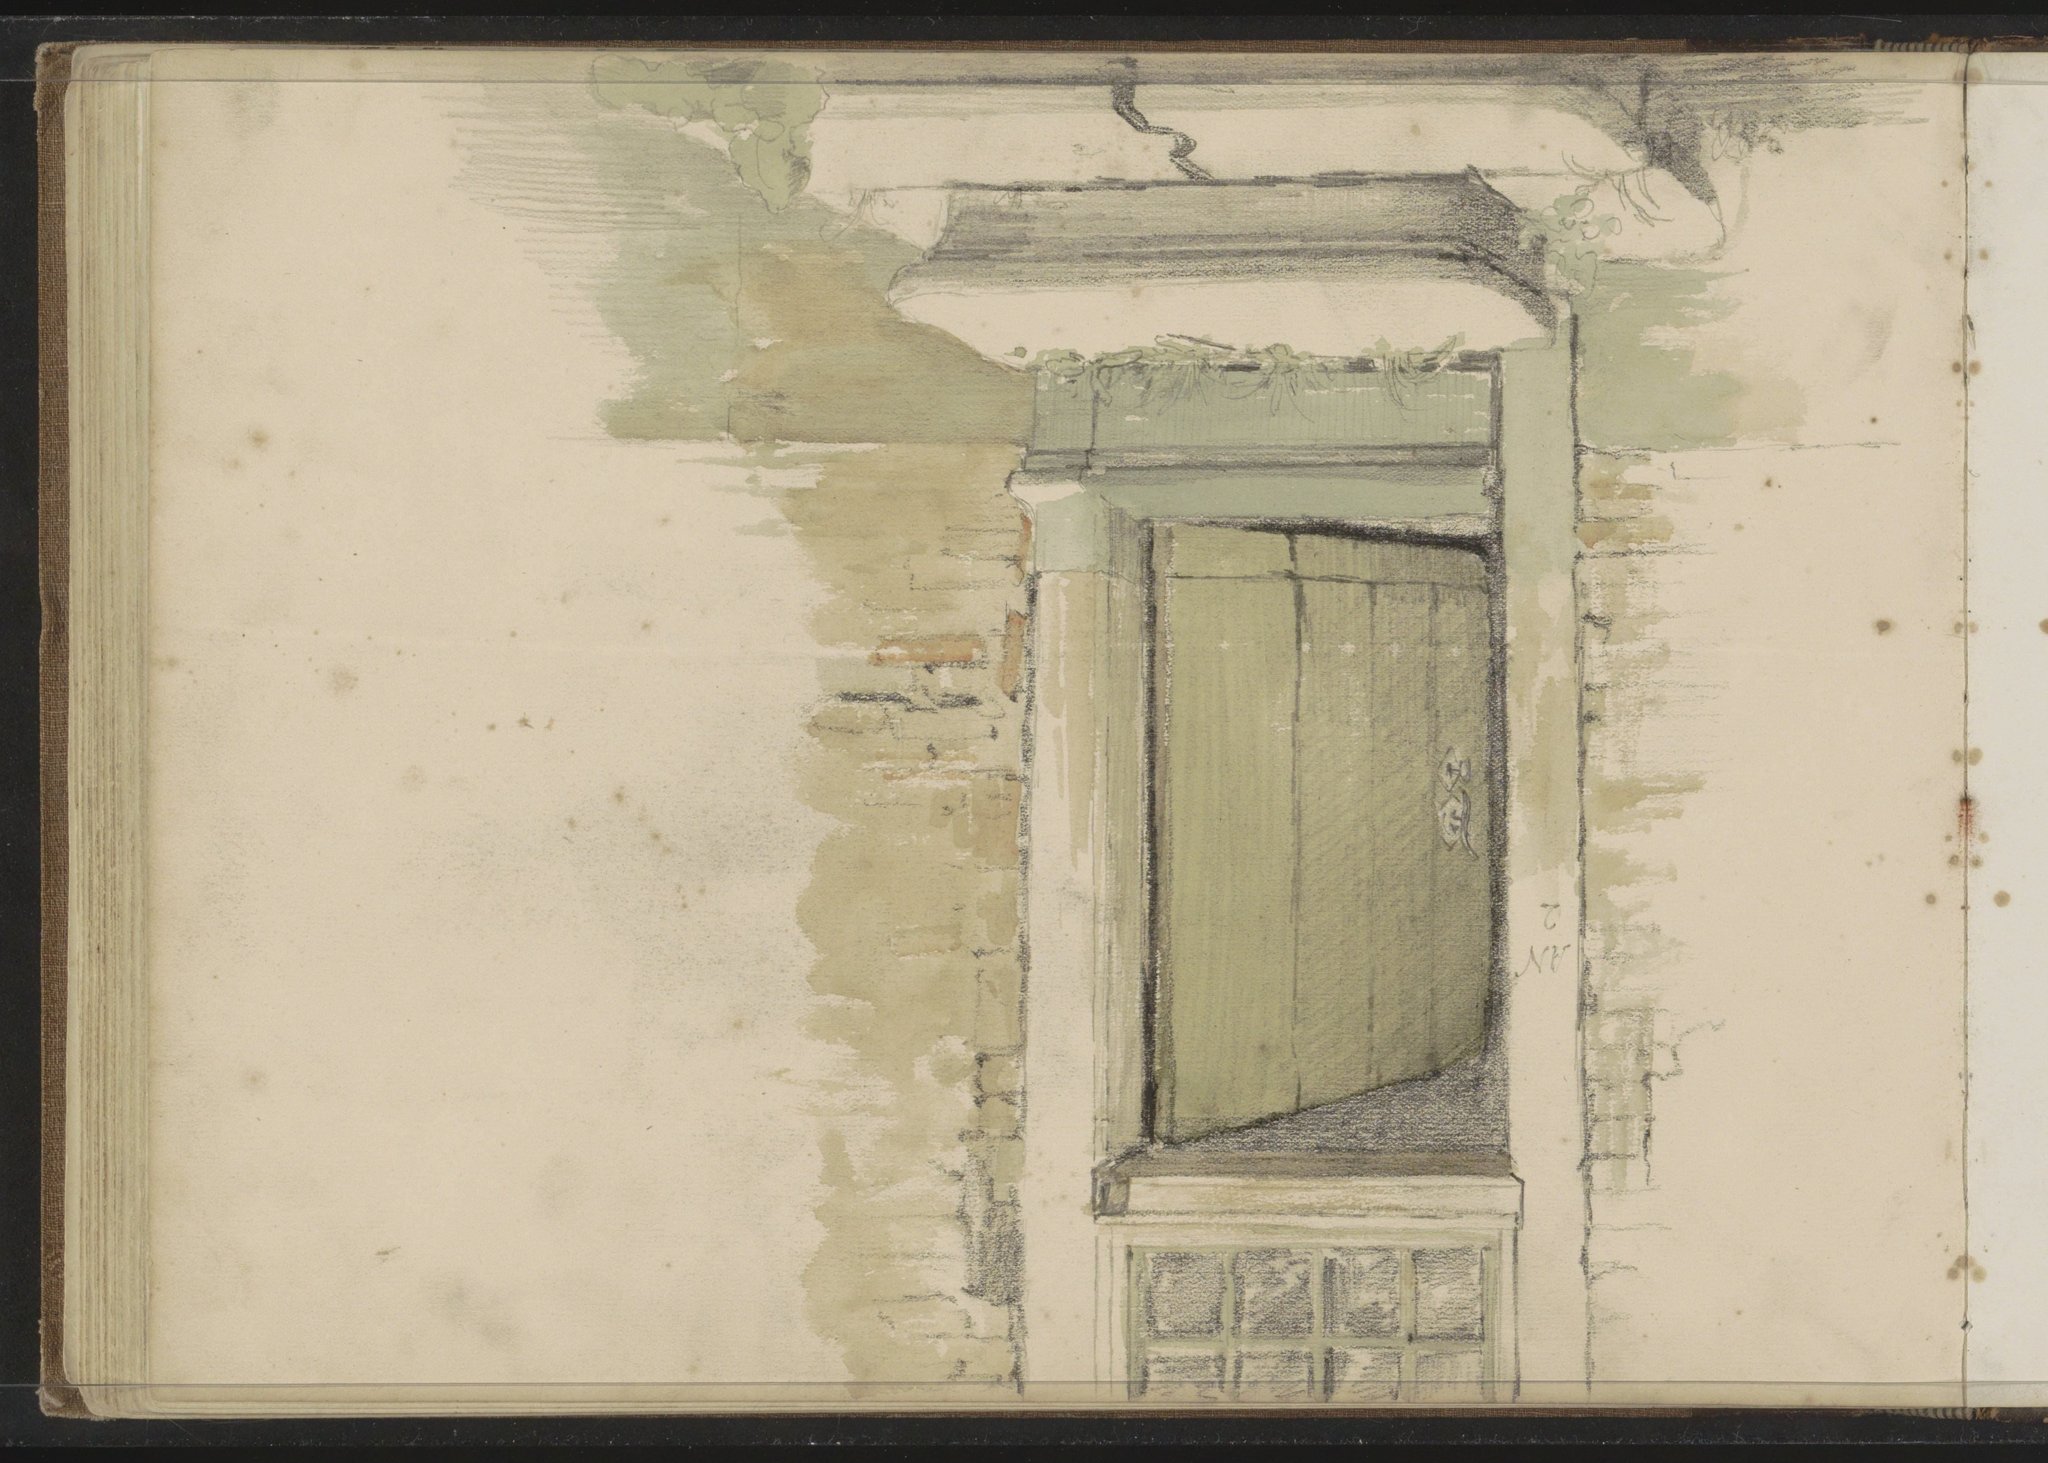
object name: sketchbook leaf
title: Voordeur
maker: hendrik valkenburg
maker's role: draughtsman, painter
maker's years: 1826-1896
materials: paper, pencil, watercolor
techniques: brush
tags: open door, front steps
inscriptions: annotation: ‘AN/ 2’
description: Blad 73 verso uit een schetsboek met 77 bladen.